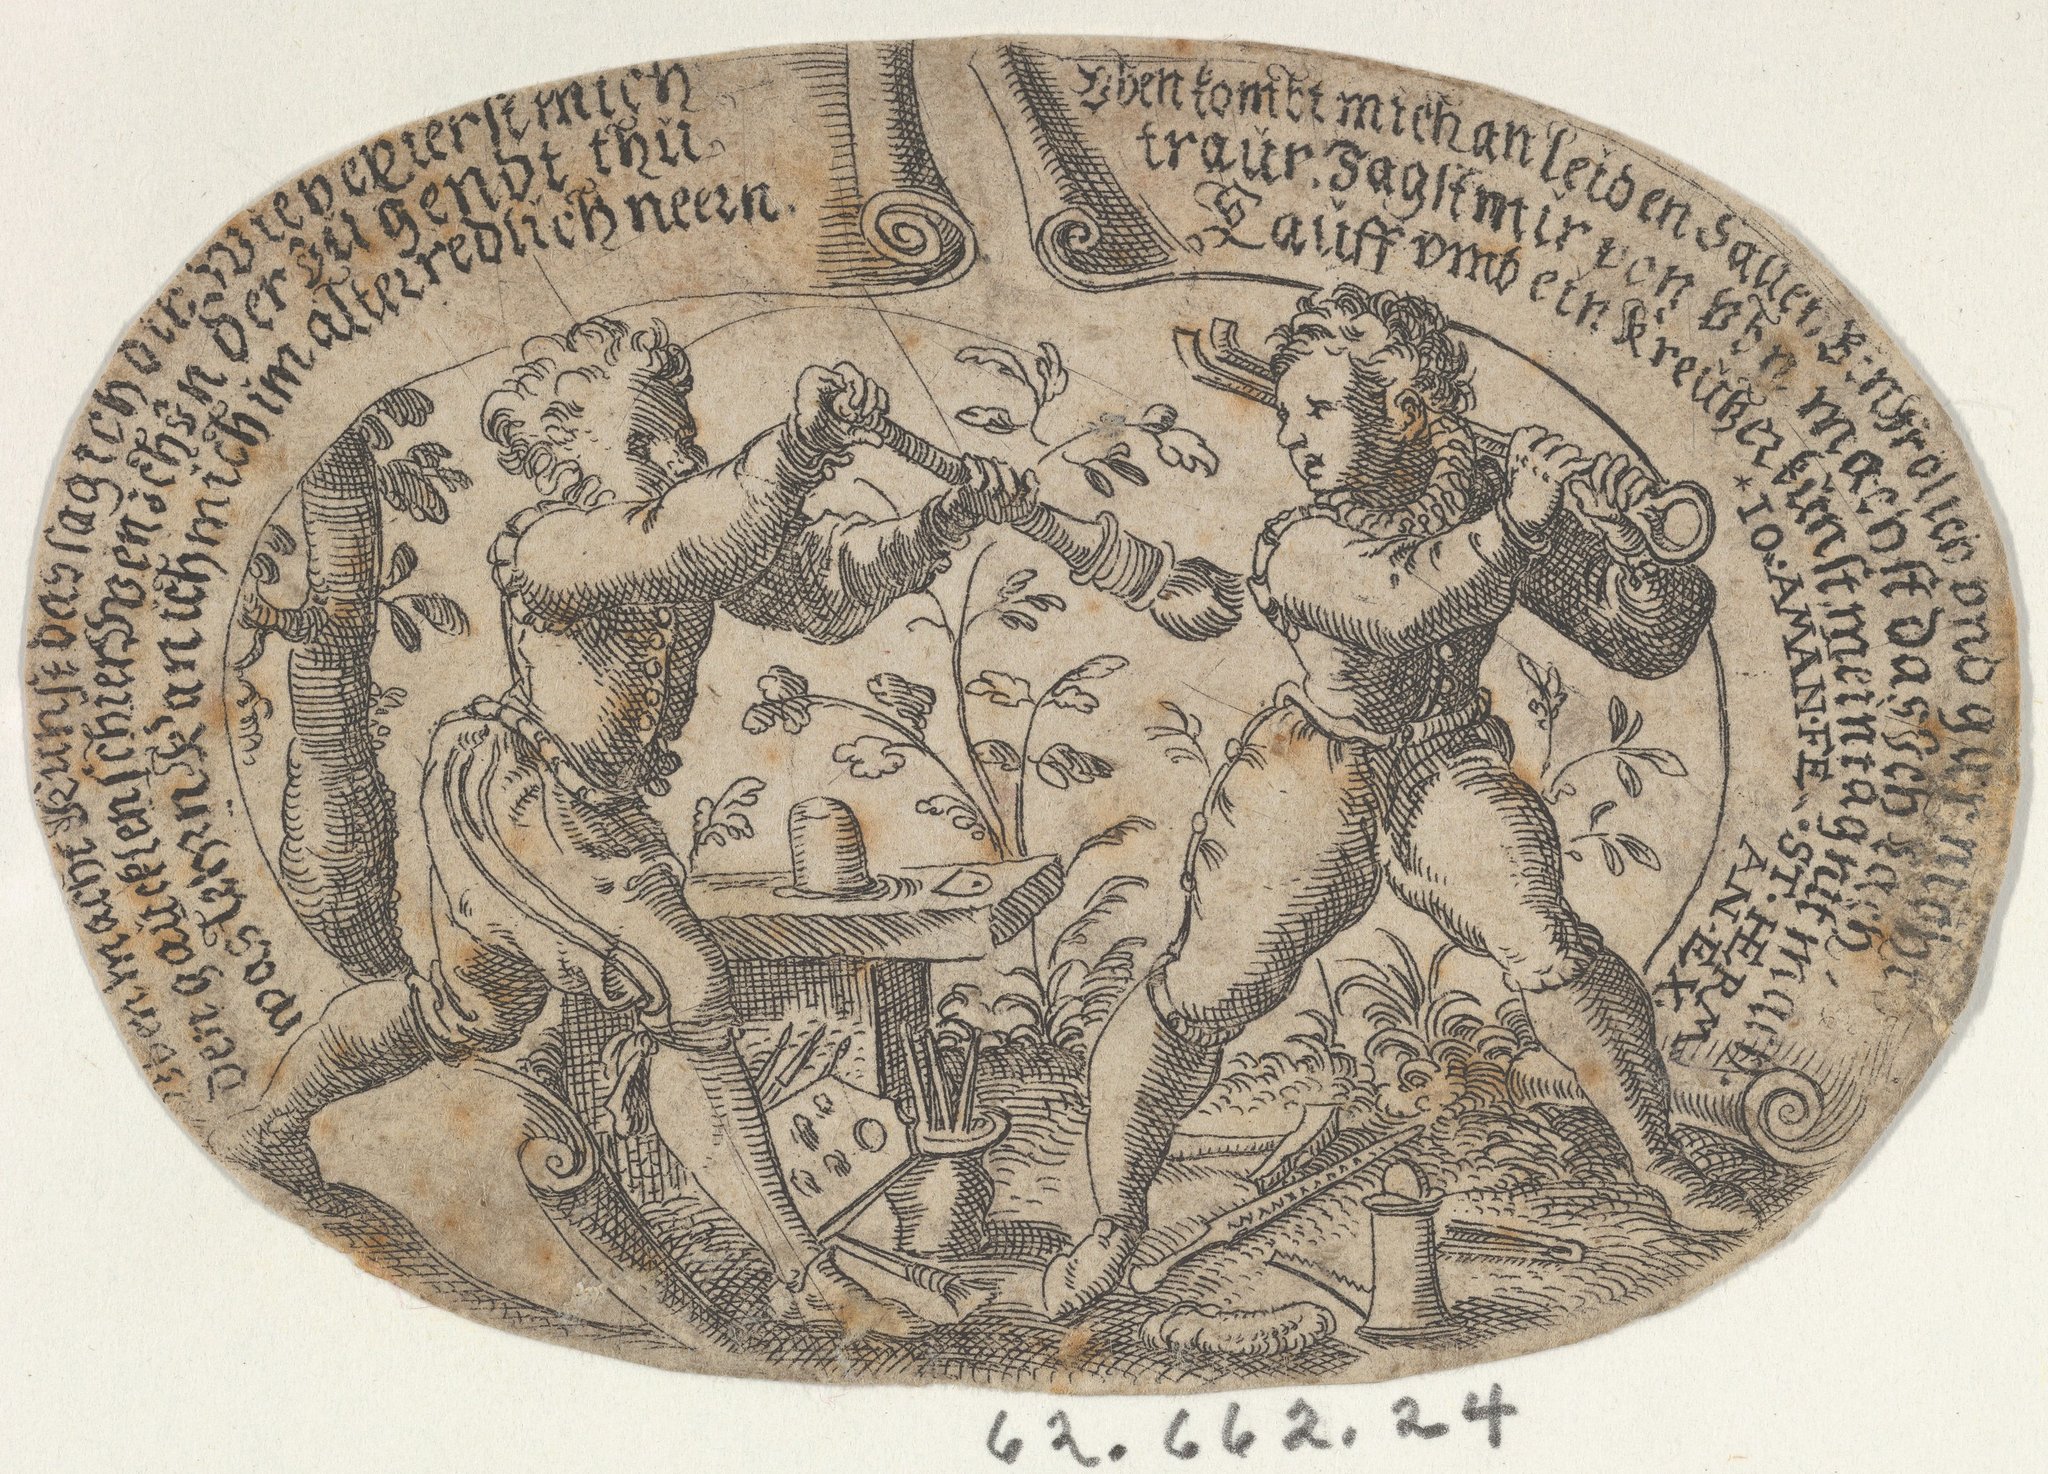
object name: print ornament architecture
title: The Young Painter and Young Goldsmith, from The Duels of the Workmen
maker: jost amman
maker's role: artist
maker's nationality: swiss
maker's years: 1539-1591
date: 1588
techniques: etching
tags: boys,brushes